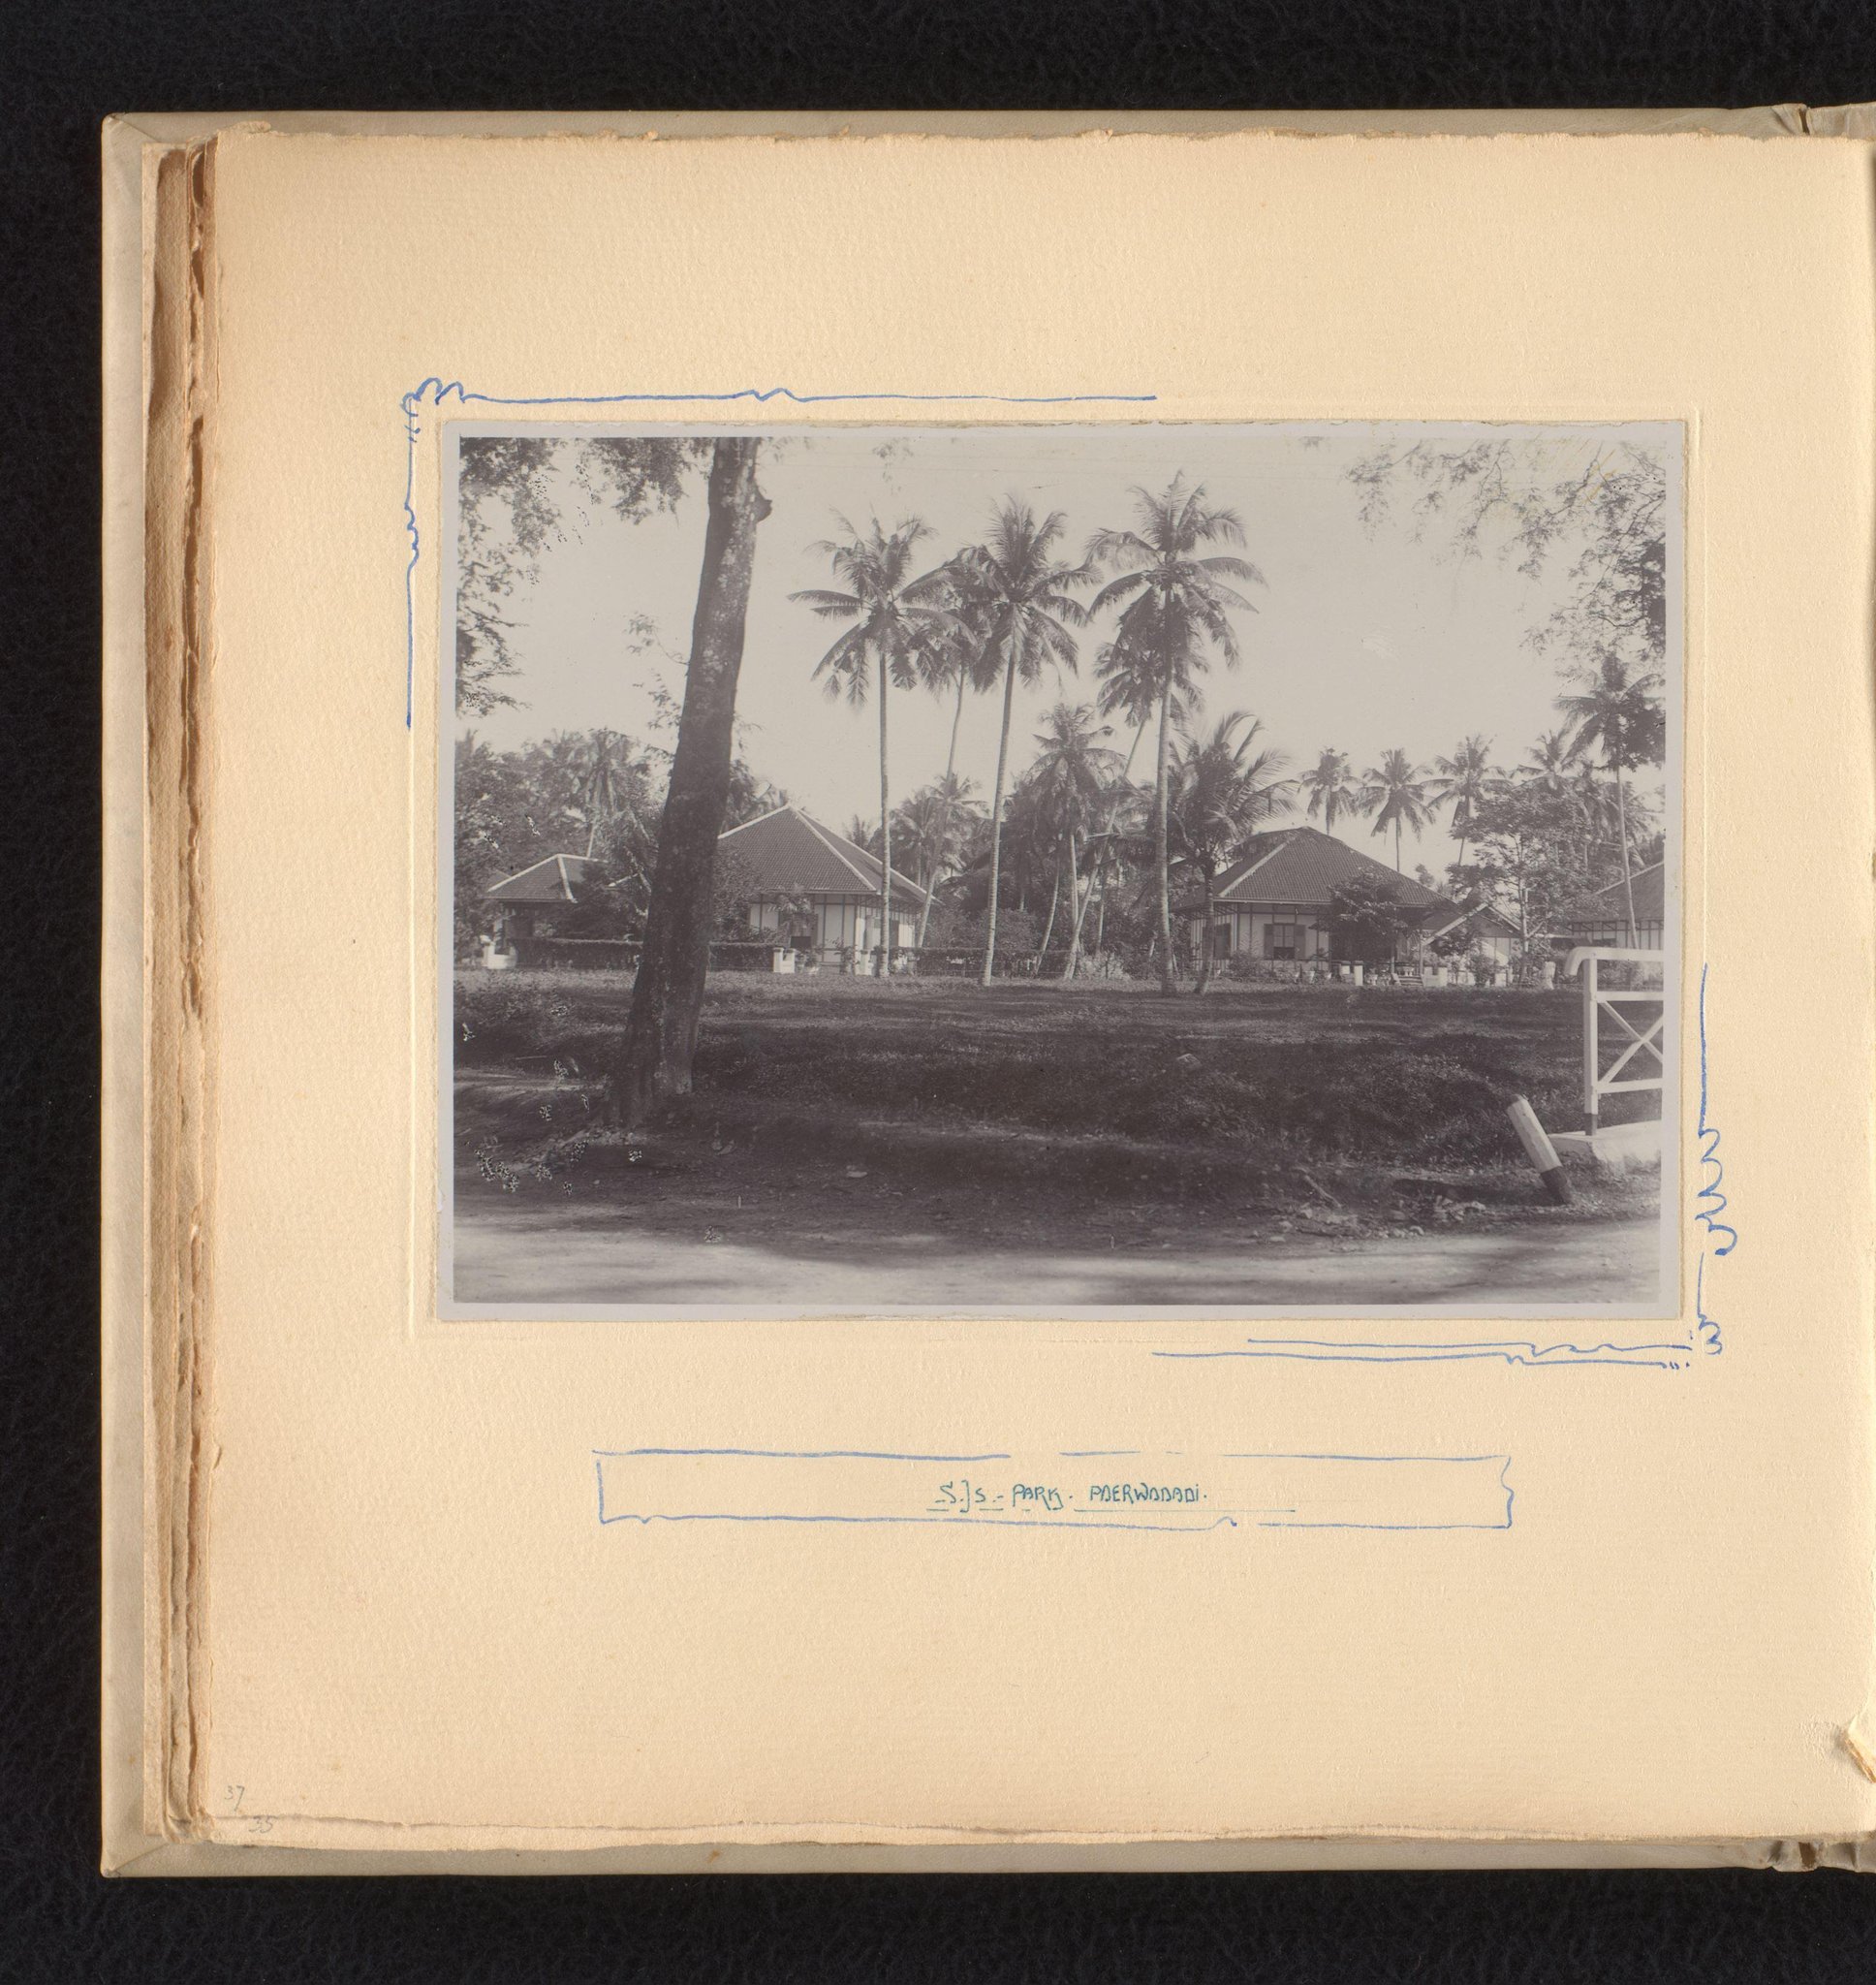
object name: album leaf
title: Woningen aan een park in Purwodadi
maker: Anonymous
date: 1910-1928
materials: paper, photographic support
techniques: drawing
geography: grobogan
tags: detached house in city, public gardens, park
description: Albumblad met een foto van wonigen aan een park (St. James Park?) in Purwodadi in Grobogan. Het blad is versierd met randwerk om de foto's. Onderdeel van het fotoalbum aangeboden aan J. Habbema door het Binnenlandsch Bestuur Corps van het Regentschap Grobogan, bij het beëindigen van zijn bestuur over het Regentschap, waarschijnlijk in 1928.